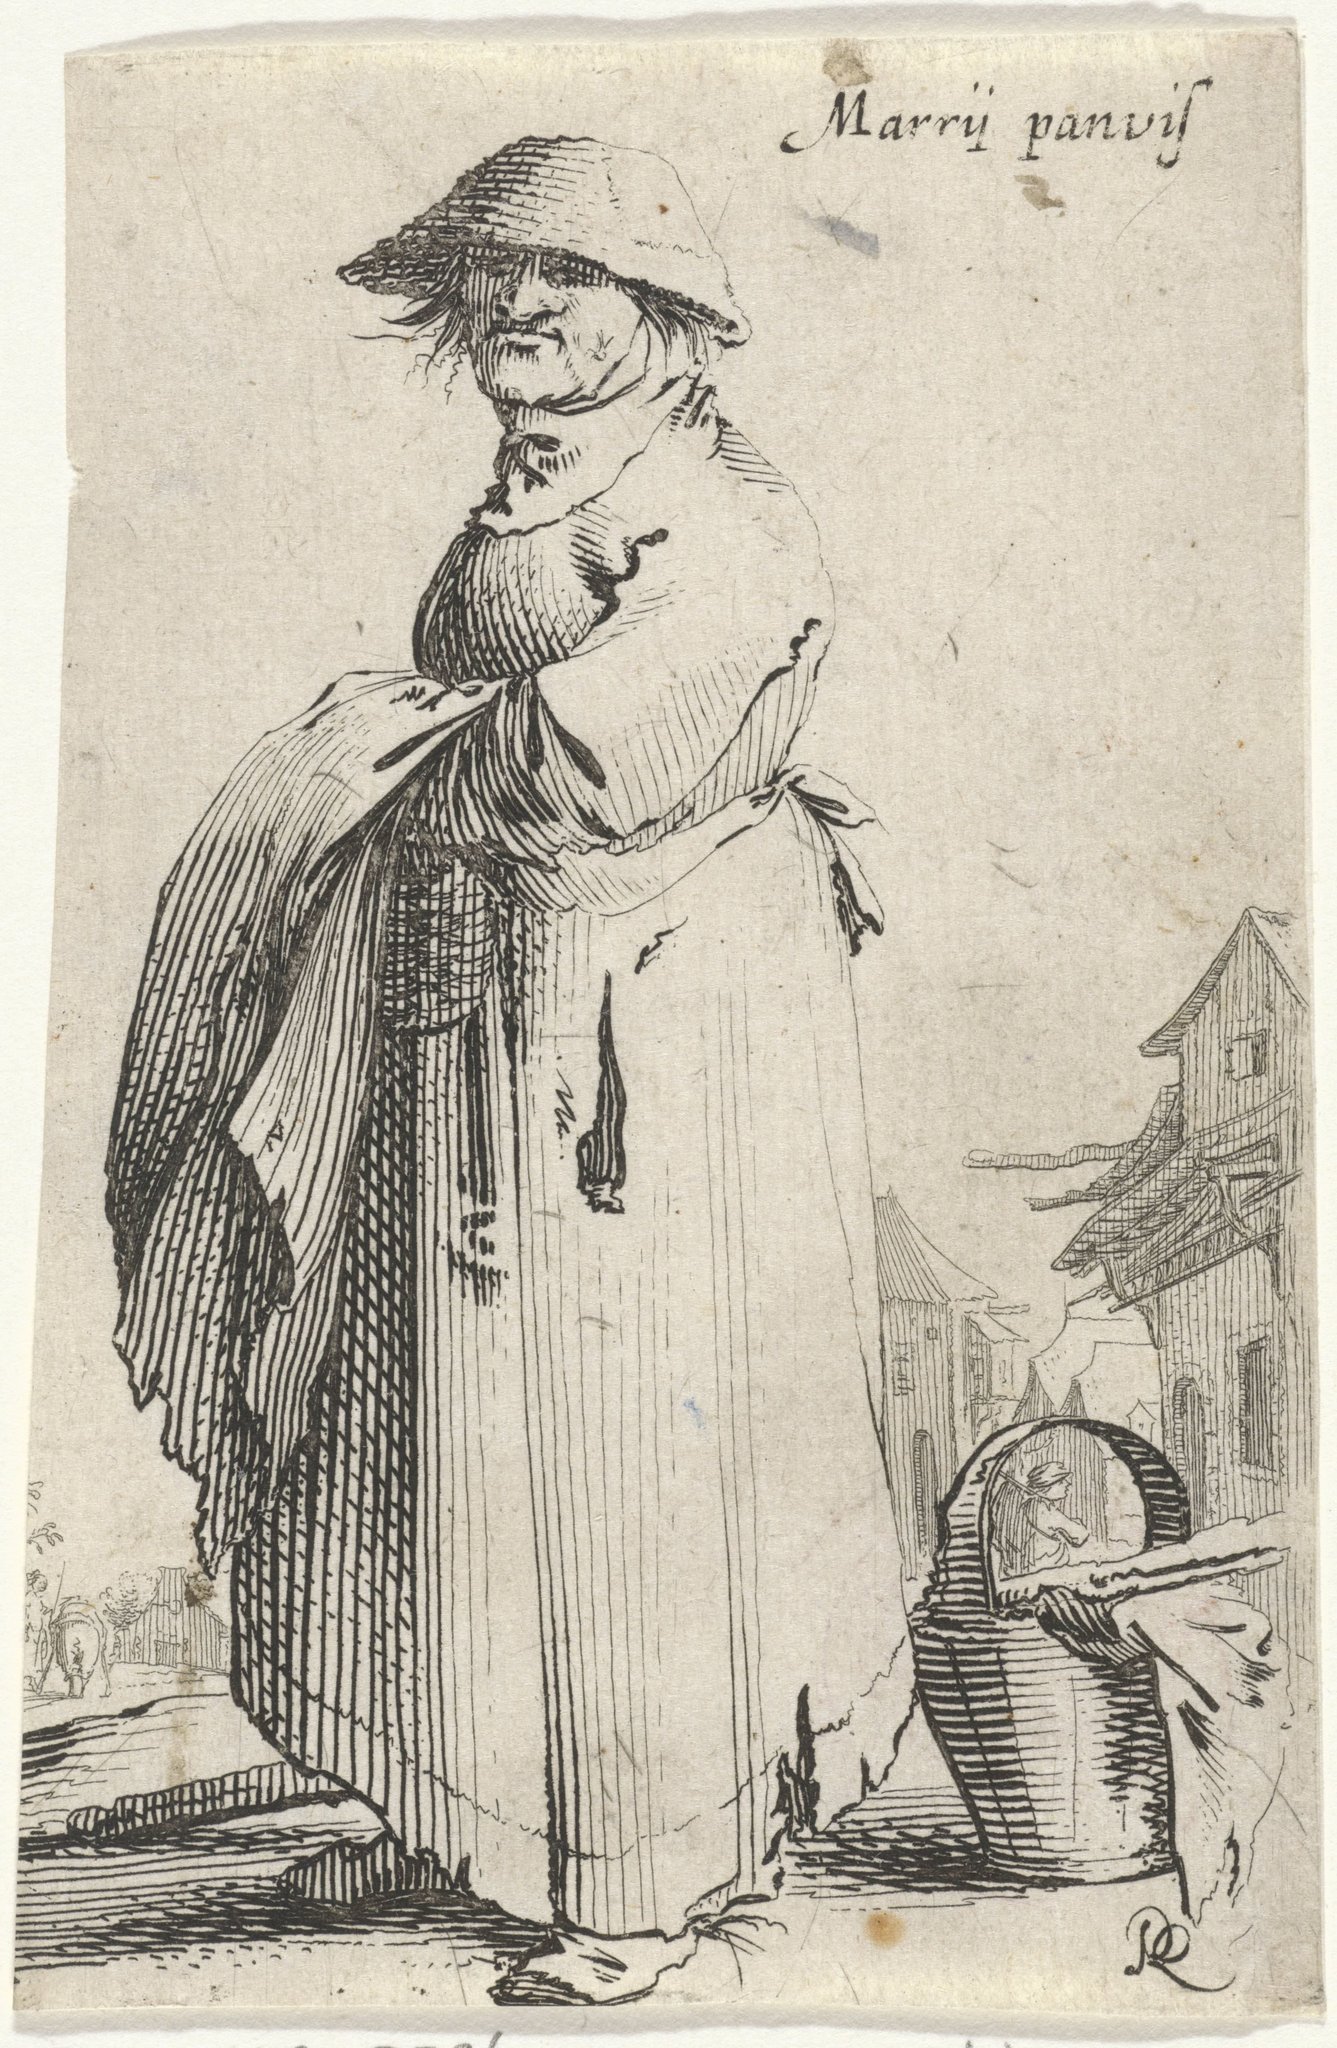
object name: print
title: Marrij panvis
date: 1630-1665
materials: paper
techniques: engraving, etching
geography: amsterdam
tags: wooden container: barrel, cask, bucket, farmers, textile fabric, cloth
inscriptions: collector's mark: Lugt 240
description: De prent maakt deel uit van een twaalfdelige serie prenten met voorstellingen van boeren.